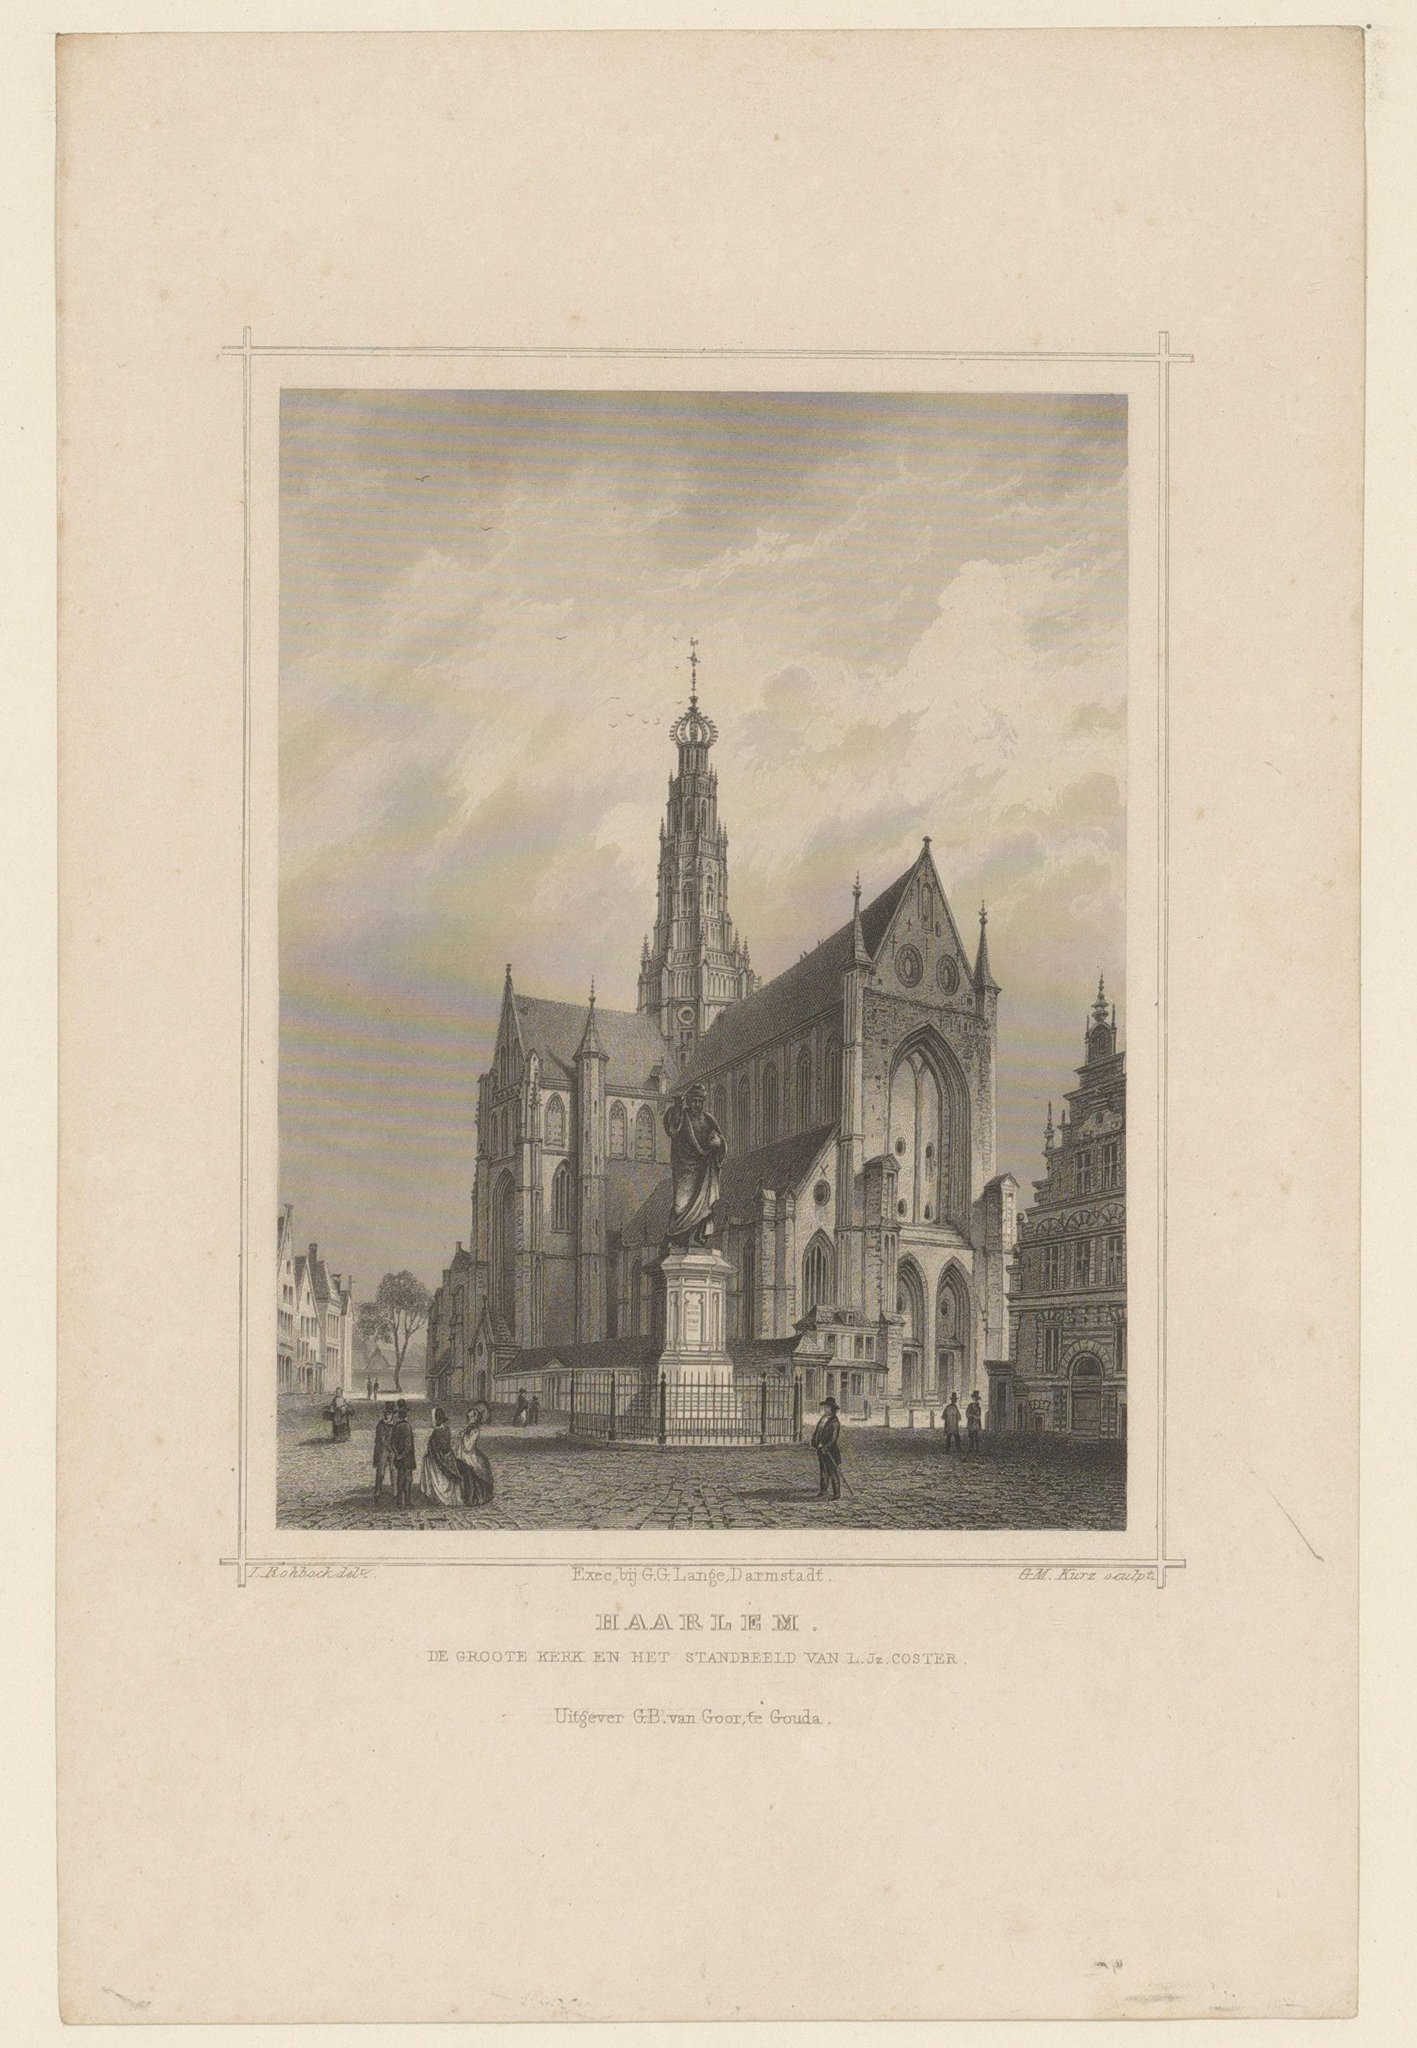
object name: print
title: Haarlem. De Groote Kerk en het standbeeld van L. Jz. Coster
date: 1855-1857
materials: paper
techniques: engraving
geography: darmstadt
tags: haarlem, church (exterior), monument, statue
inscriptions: collector's mark: Lugt 1641, collector's mark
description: Prent uit: Terwen, J.L. Het koningrijk der Nederlanden (...). 2 dln. Gouda: G.B. van Goor, 1857. Dezelfde prent, met een ander onderschrift, komt ook voor in: Der Rhein und die Rheinlande in malerischen Original-ansichten. 3 dln. Darmstadt: G.G. Lange, 1863.